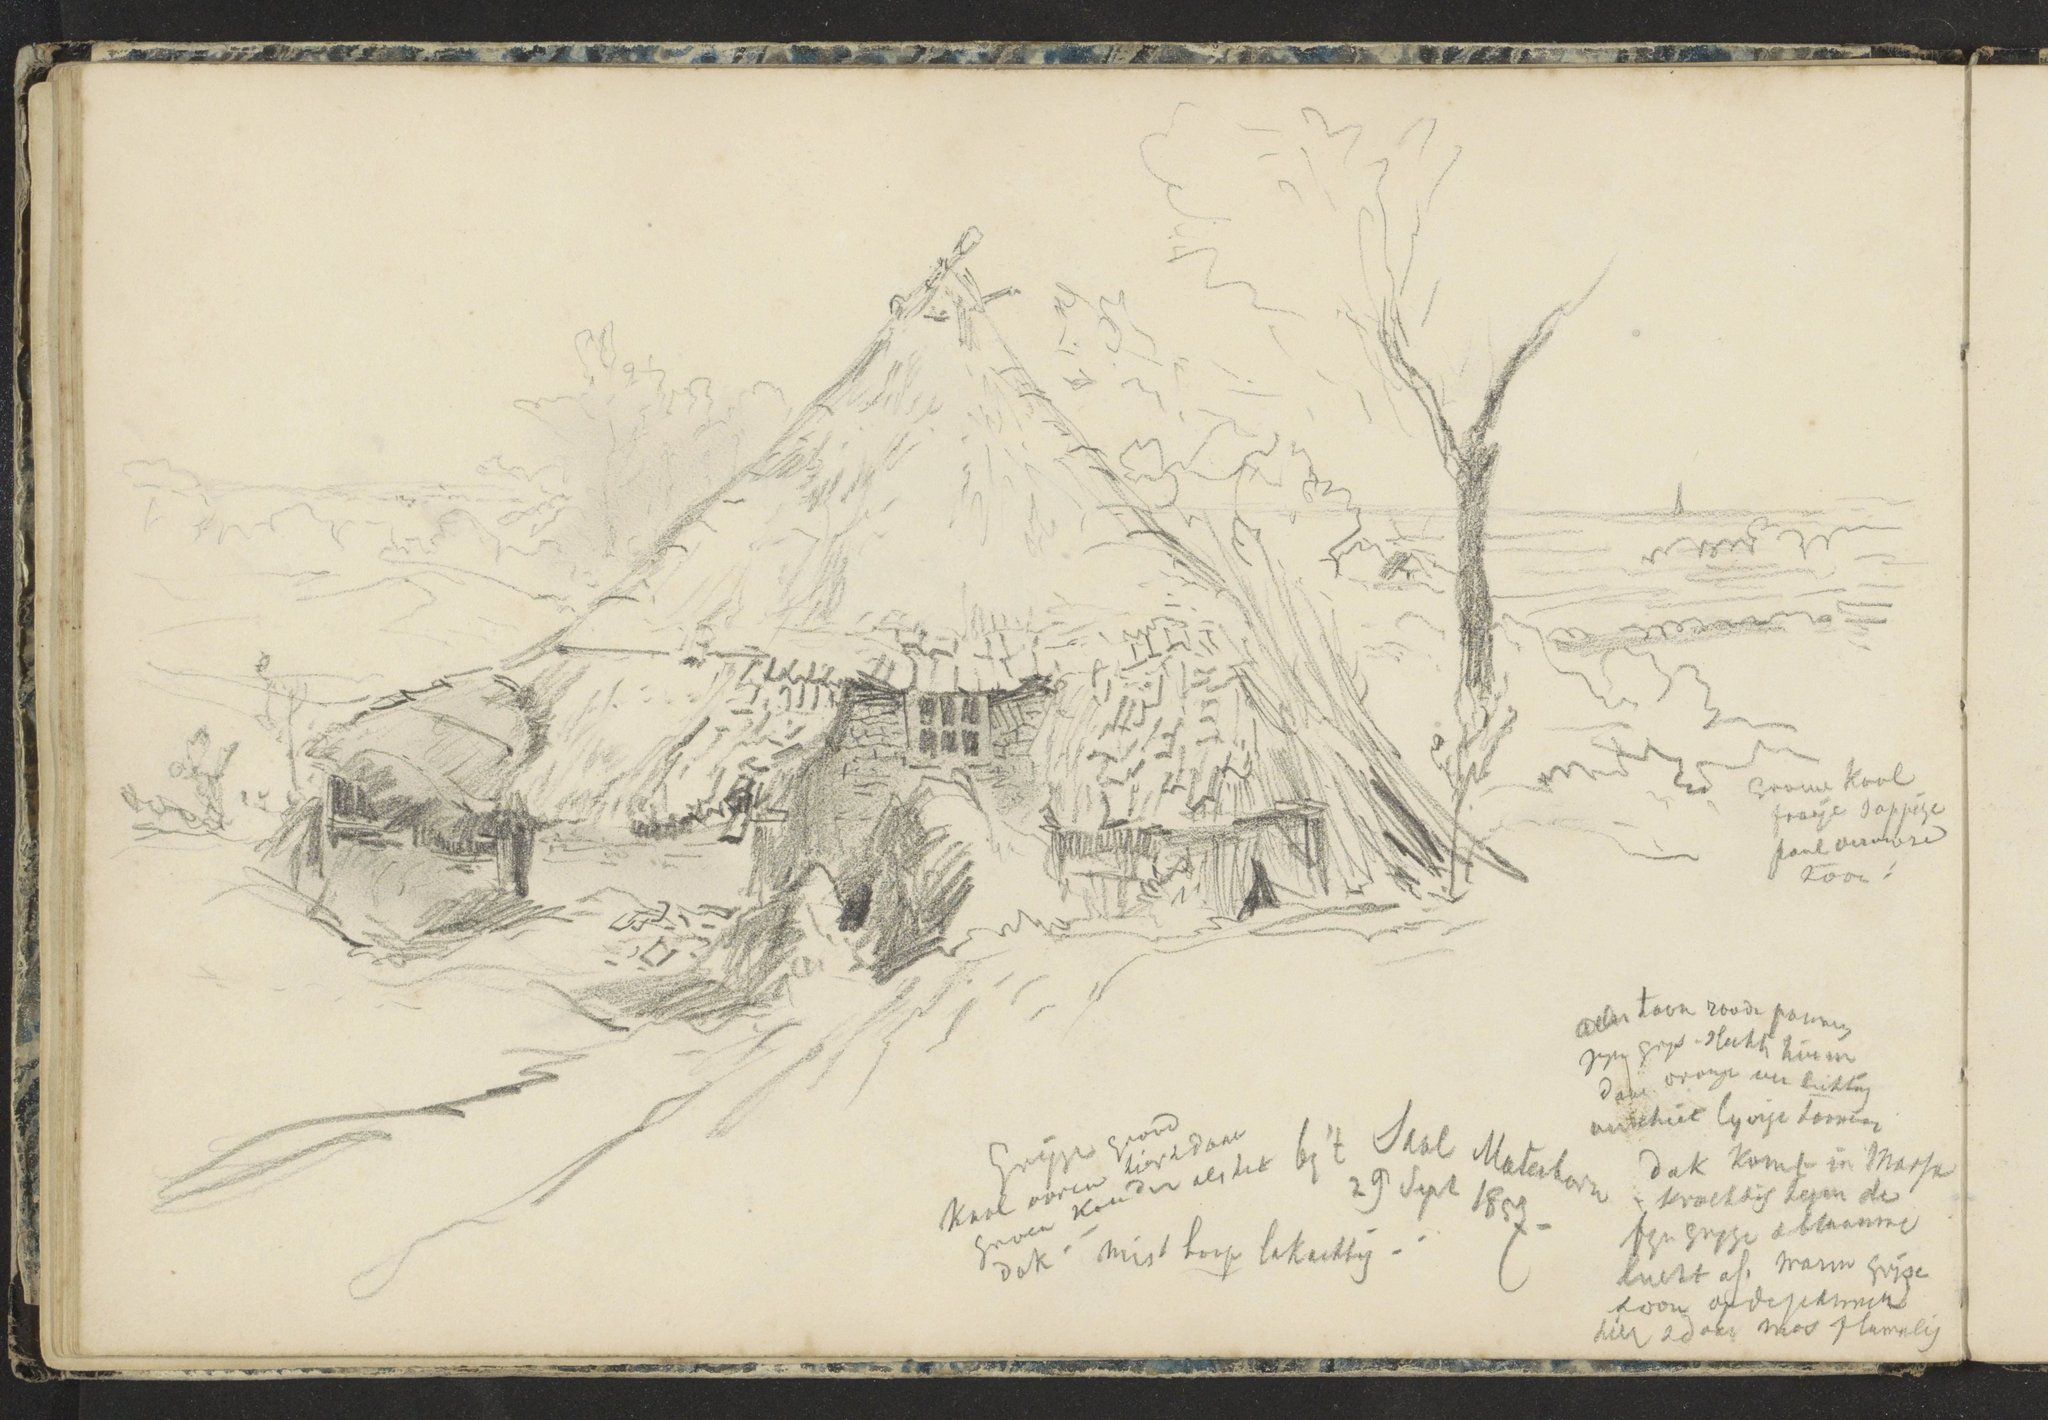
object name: sketchbook leaf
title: Boerenwoning met rieten dak bij 't Saal in Materborn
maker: johannes tavenraat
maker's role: draughtsman, painter, print maker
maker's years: 1809-1881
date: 1857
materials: paper, pencil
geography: materborn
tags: city-view, and landscape with man-made constructions, rural housing, e.g. country-house, villa, cottage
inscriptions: date and inscription: ‘bij 't Saal Materborn/ 29 Sept 1857.’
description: Blad 19 verso uit een schetsboek met 44 bladen.